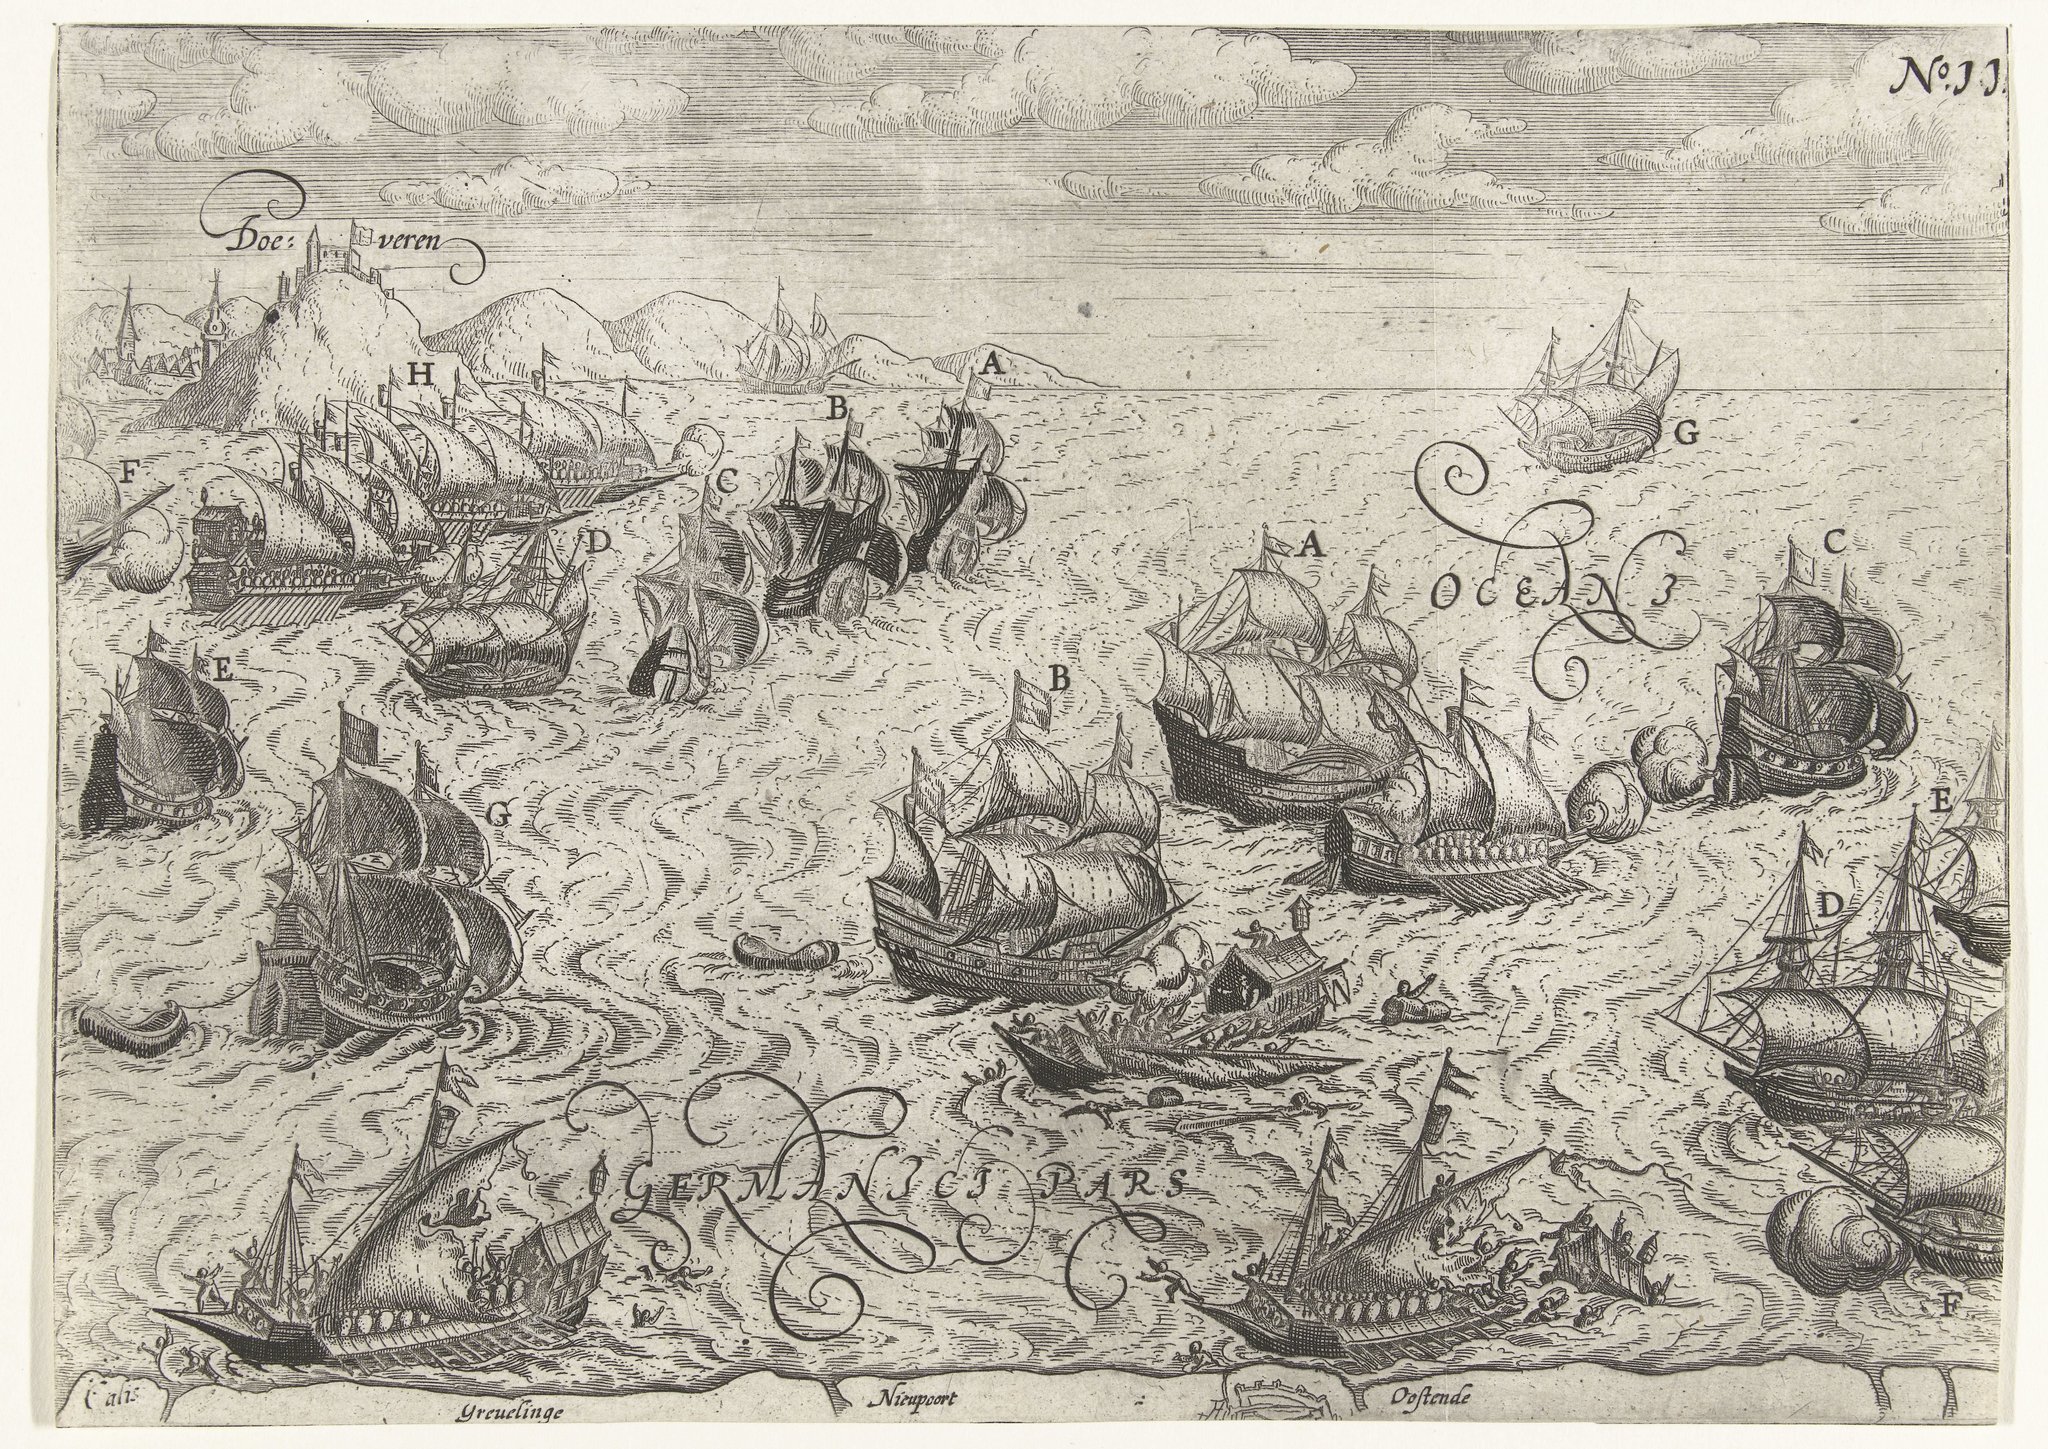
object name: print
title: Vernietiging van Spaanse galeien, 3 oktober 1602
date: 1603-1604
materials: paper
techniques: etching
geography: low countries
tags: battle (+ naval force), warfare; military affairs (+ oared ships, e.g.: galley), trireme, galley, english channel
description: Eerst gebruikt in contemporaine journalen van het beleg van Oostende uit 1604 (exemplaren in de collectie van de Rijksmuseum Research Library (326 F 10 en 326 F 11). Later gebruikt in H. van Haestens, De Bloedige ende strenge Belegeringhe Der Stadt Oostende in Vlaenderen, Leiden 1613. In deze opgewerkte en hernummerde staat afkomstig uit de Franse uitgave: H. Haestens, La nouvelle Troye ou memorable histoire du siege d’Ostende, Leiden 1615.